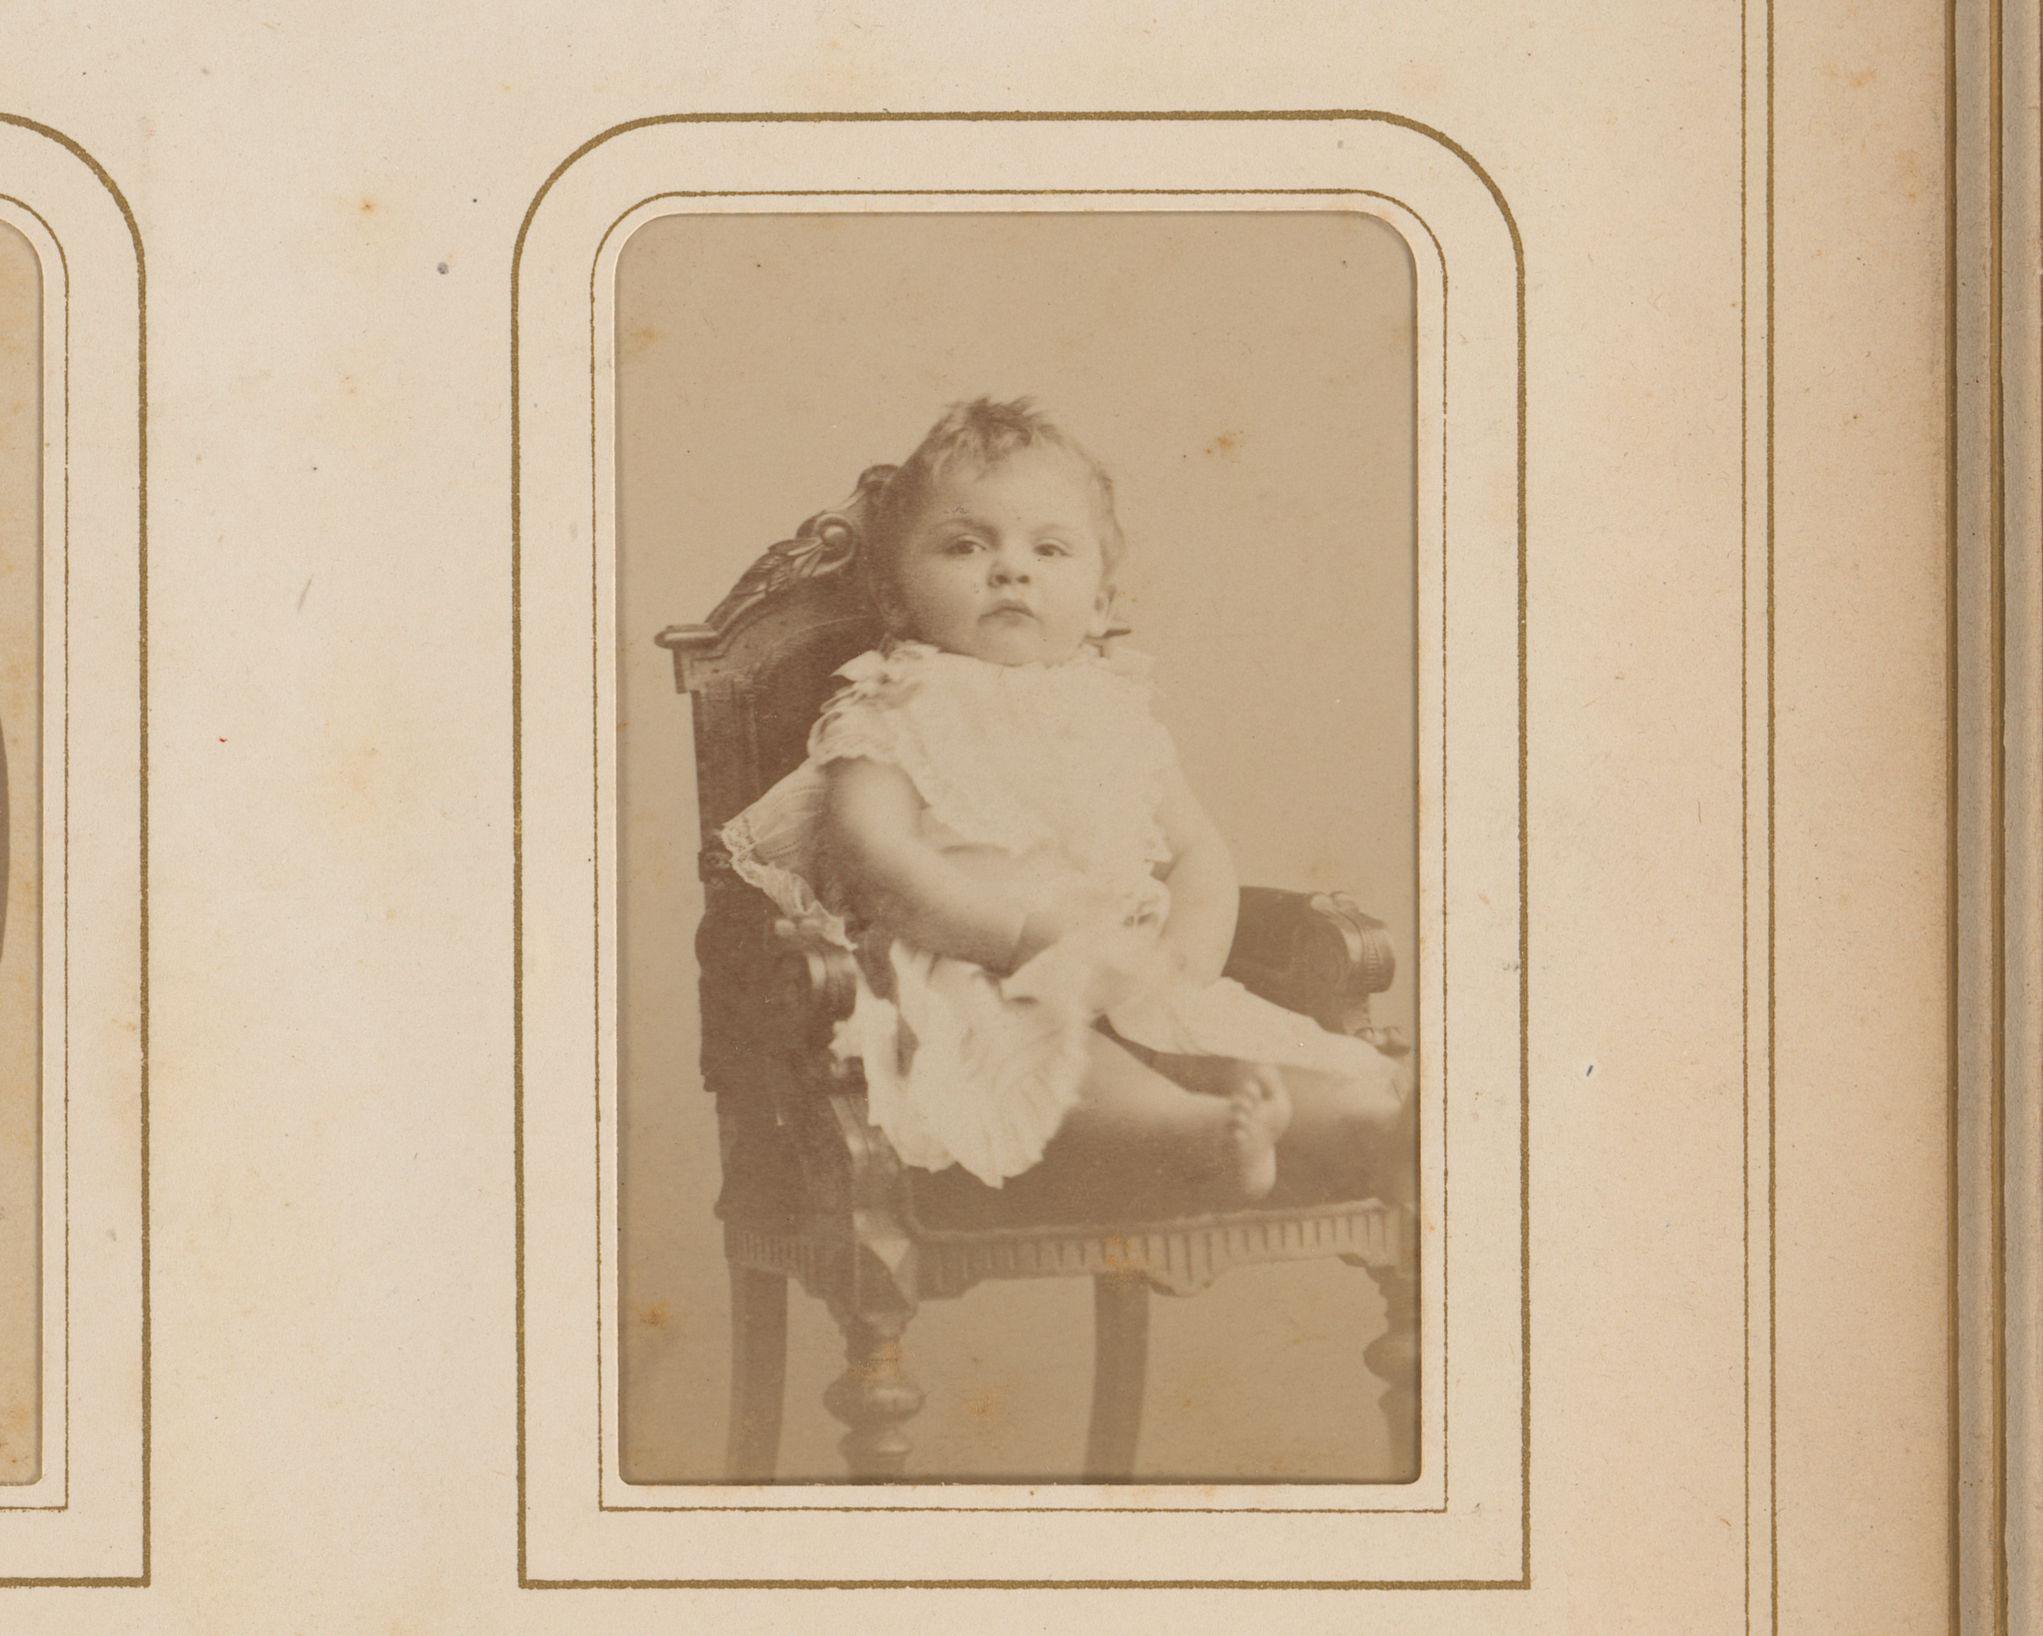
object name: photograph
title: Portret van een peuter op een stoel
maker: max büttinghausen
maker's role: fotograaf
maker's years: 1847-1906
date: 1886-1900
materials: cardboard, photographic support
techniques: albumen print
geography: amsterdam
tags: historical persons, toddler (female), chair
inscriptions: inscription: ‘M. BÜTTINGHAUSEN/ Photographisch artistisch Atelier/ Amsterdam/ Kalverstraat/ hoek Spui/ eenig Atelier/ Specialiteit in Vergrootingen./ Kooldruk./ Onveranderlijk./ De plaat blijft ter nabestelling bewaard.’